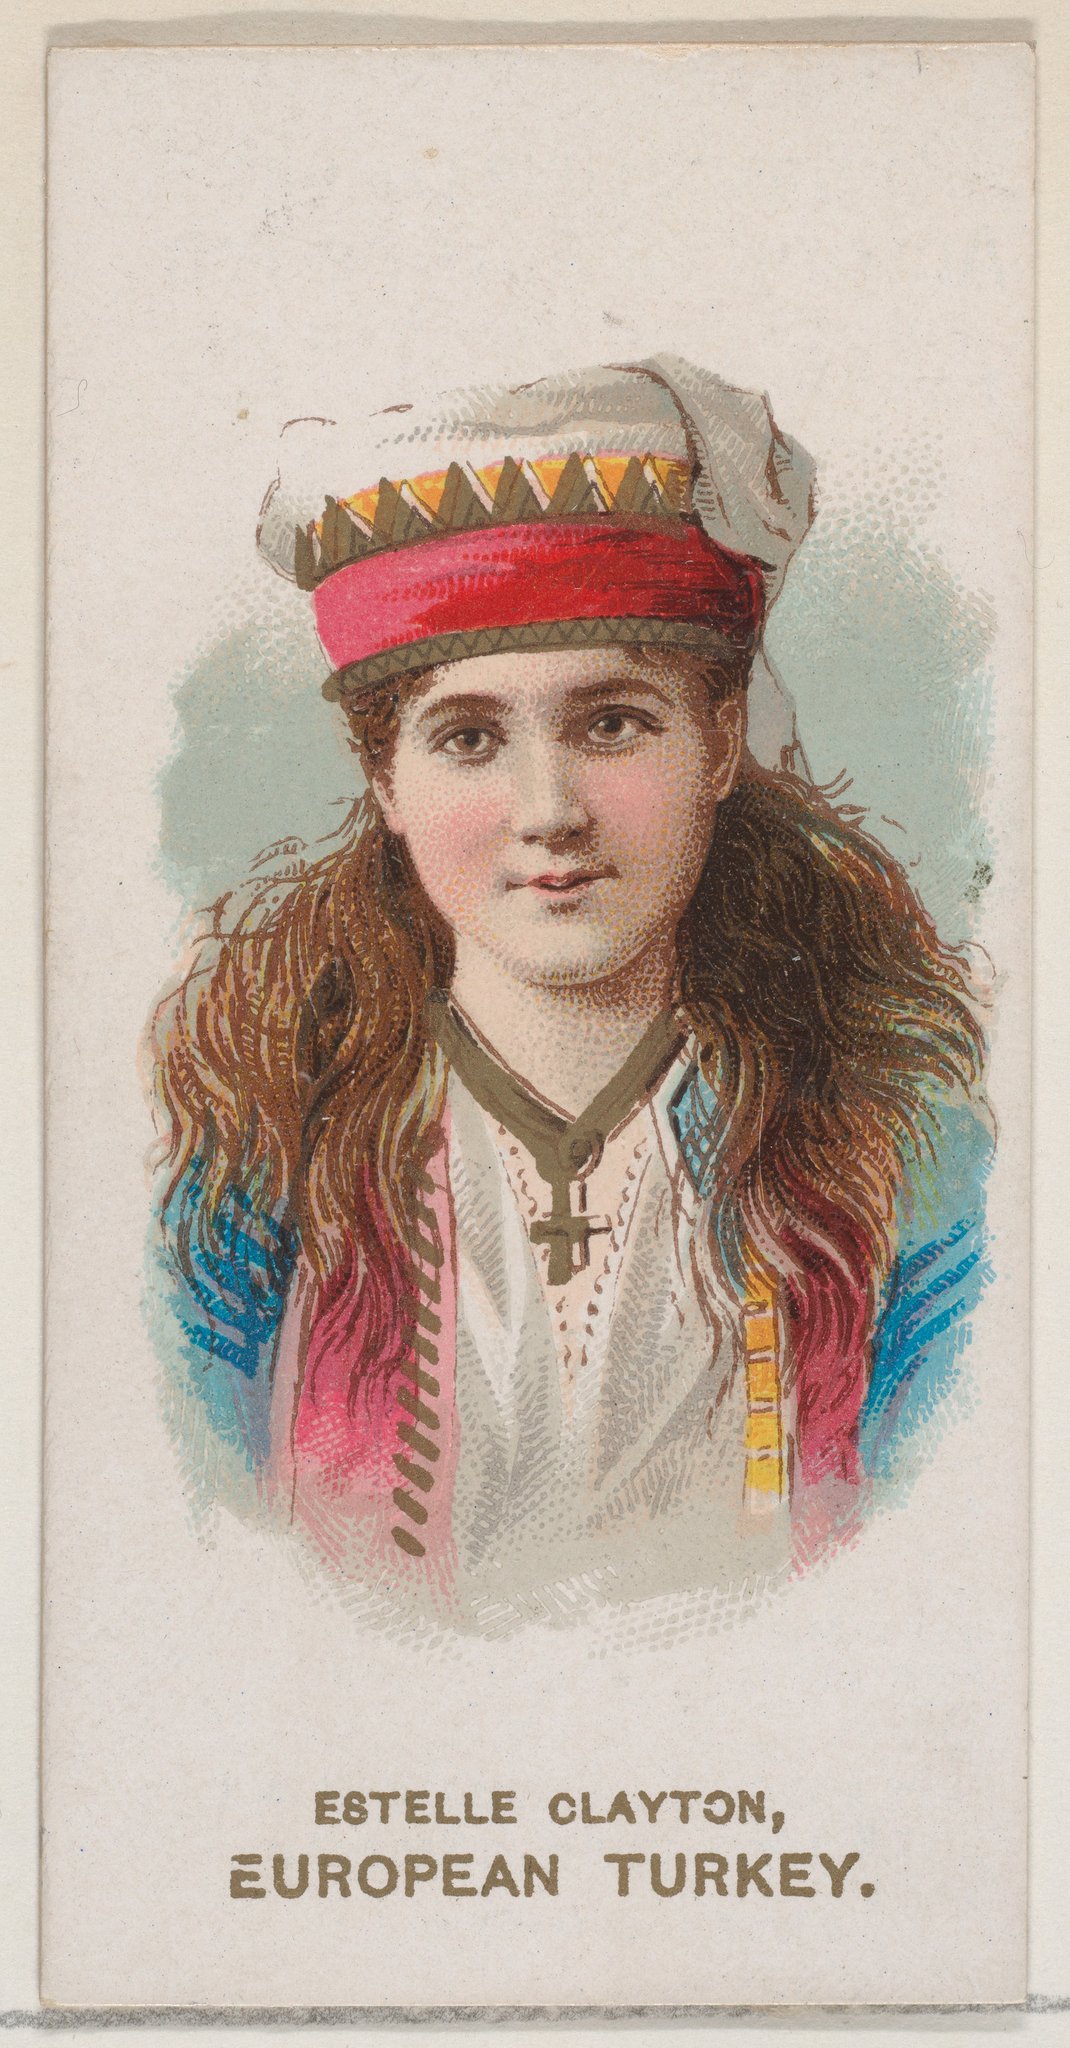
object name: print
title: Estelle Clayton in Costume of European Turkey, from the set Actors and Actresses, Second Series (N71) for Duke brand cigarettes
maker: w. duke, sons & co.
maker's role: publisher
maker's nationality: american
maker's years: 1870-1920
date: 1888-1890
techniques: color lithograph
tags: women,actresses